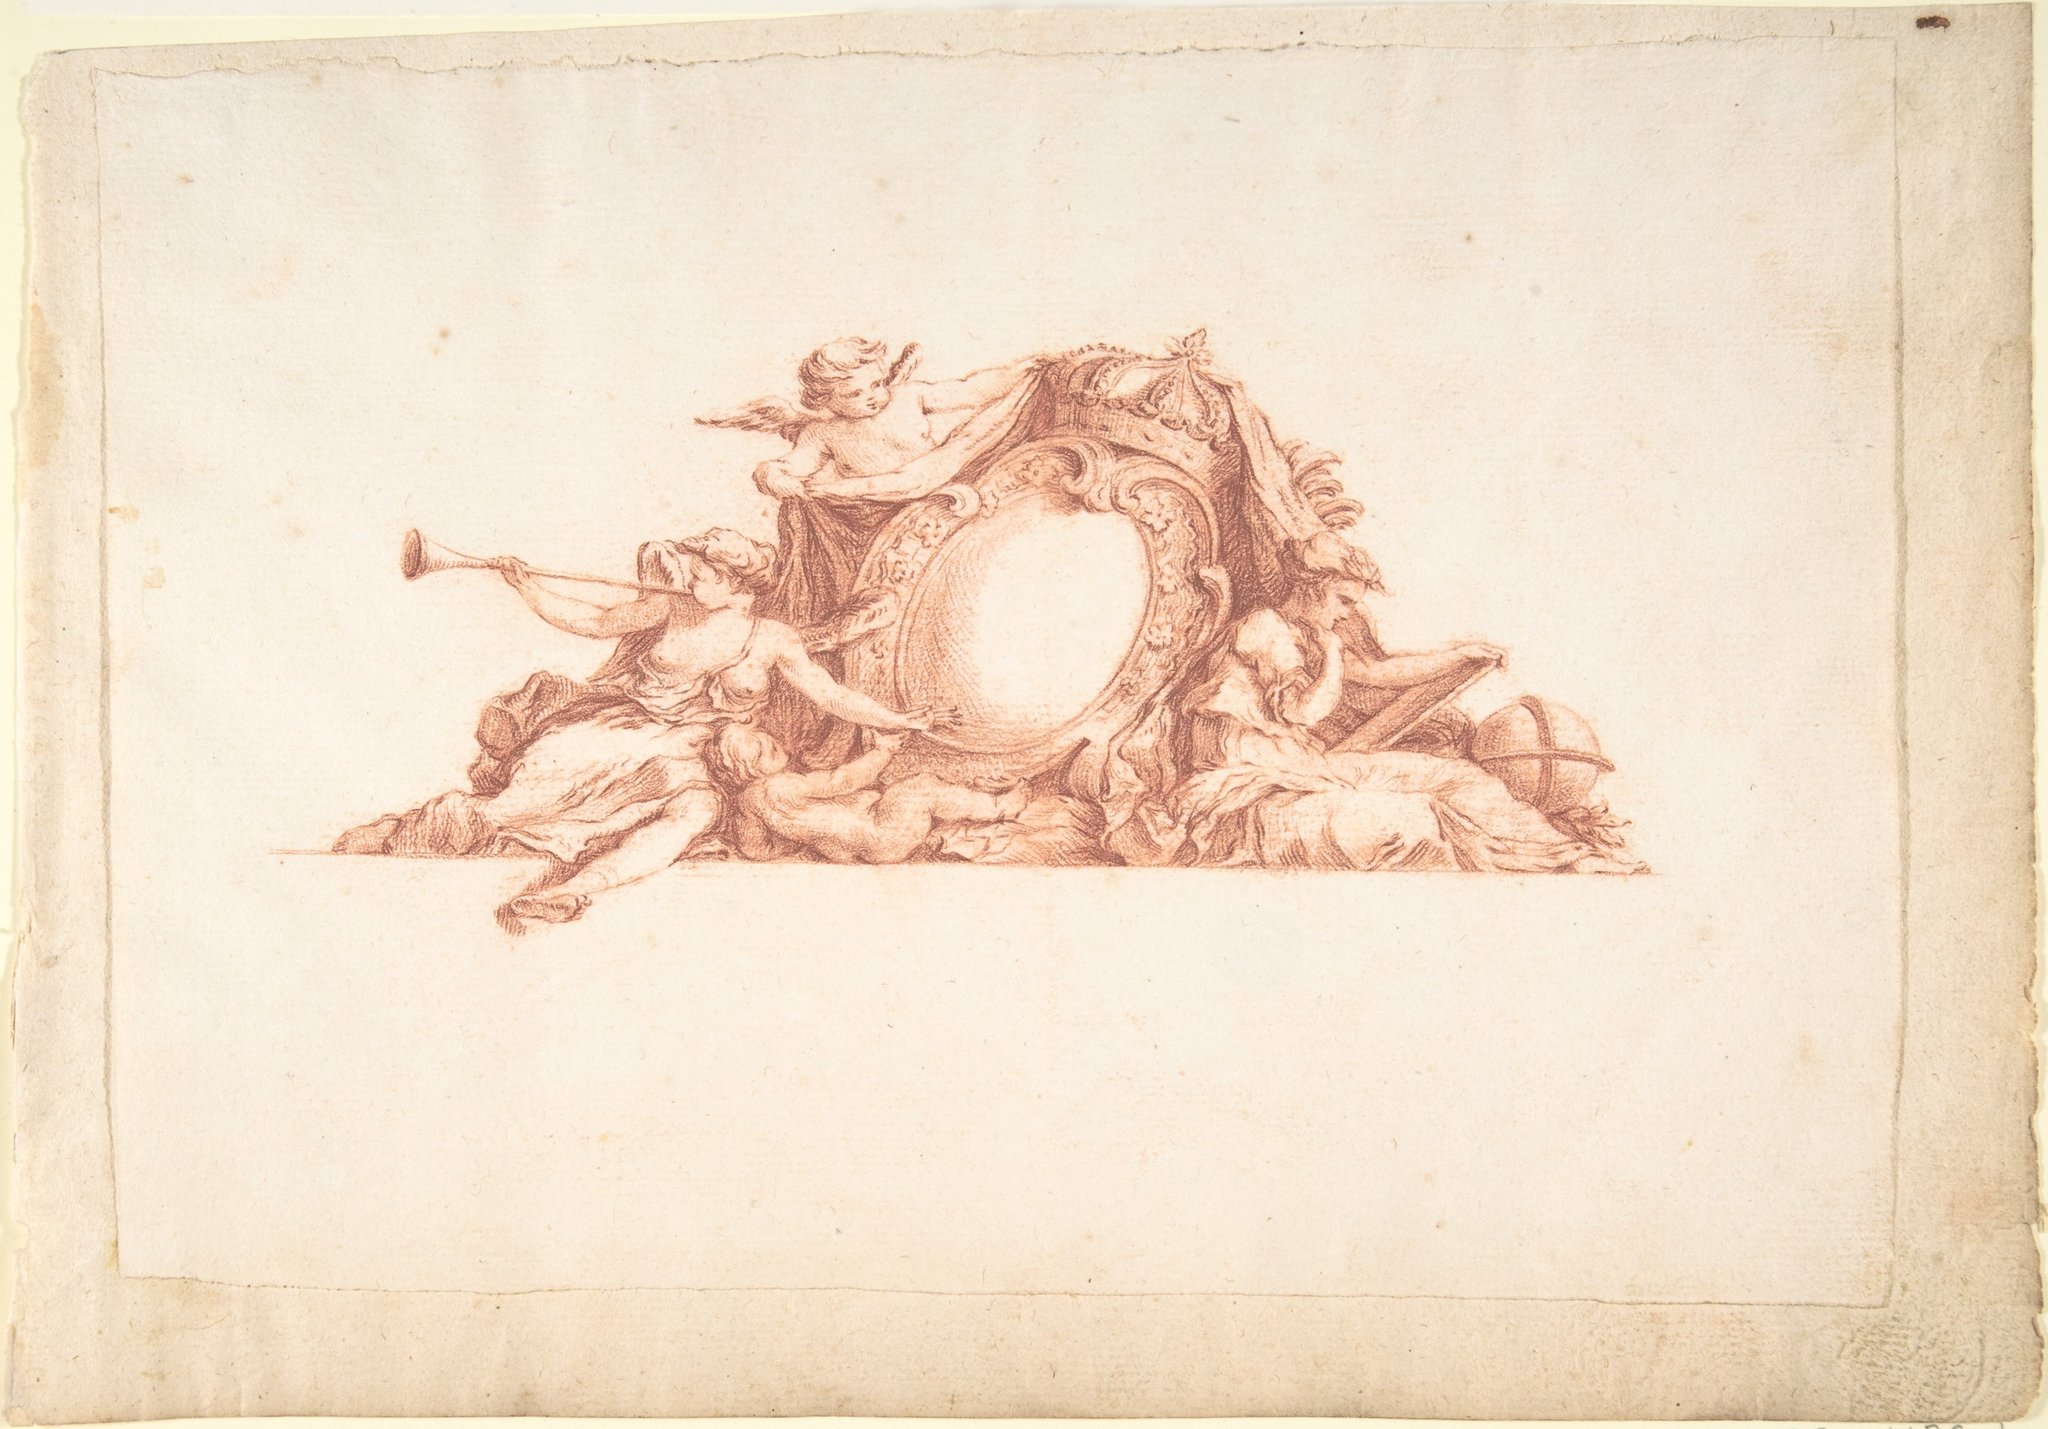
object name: drawing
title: Preparatory Study for Plate 34 in "Maisons de plaisance" Vol. II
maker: jacques françois blondel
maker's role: artist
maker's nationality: french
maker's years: 1705-1774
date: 1701-1800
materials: chalk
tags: musical instruments,women,emblems